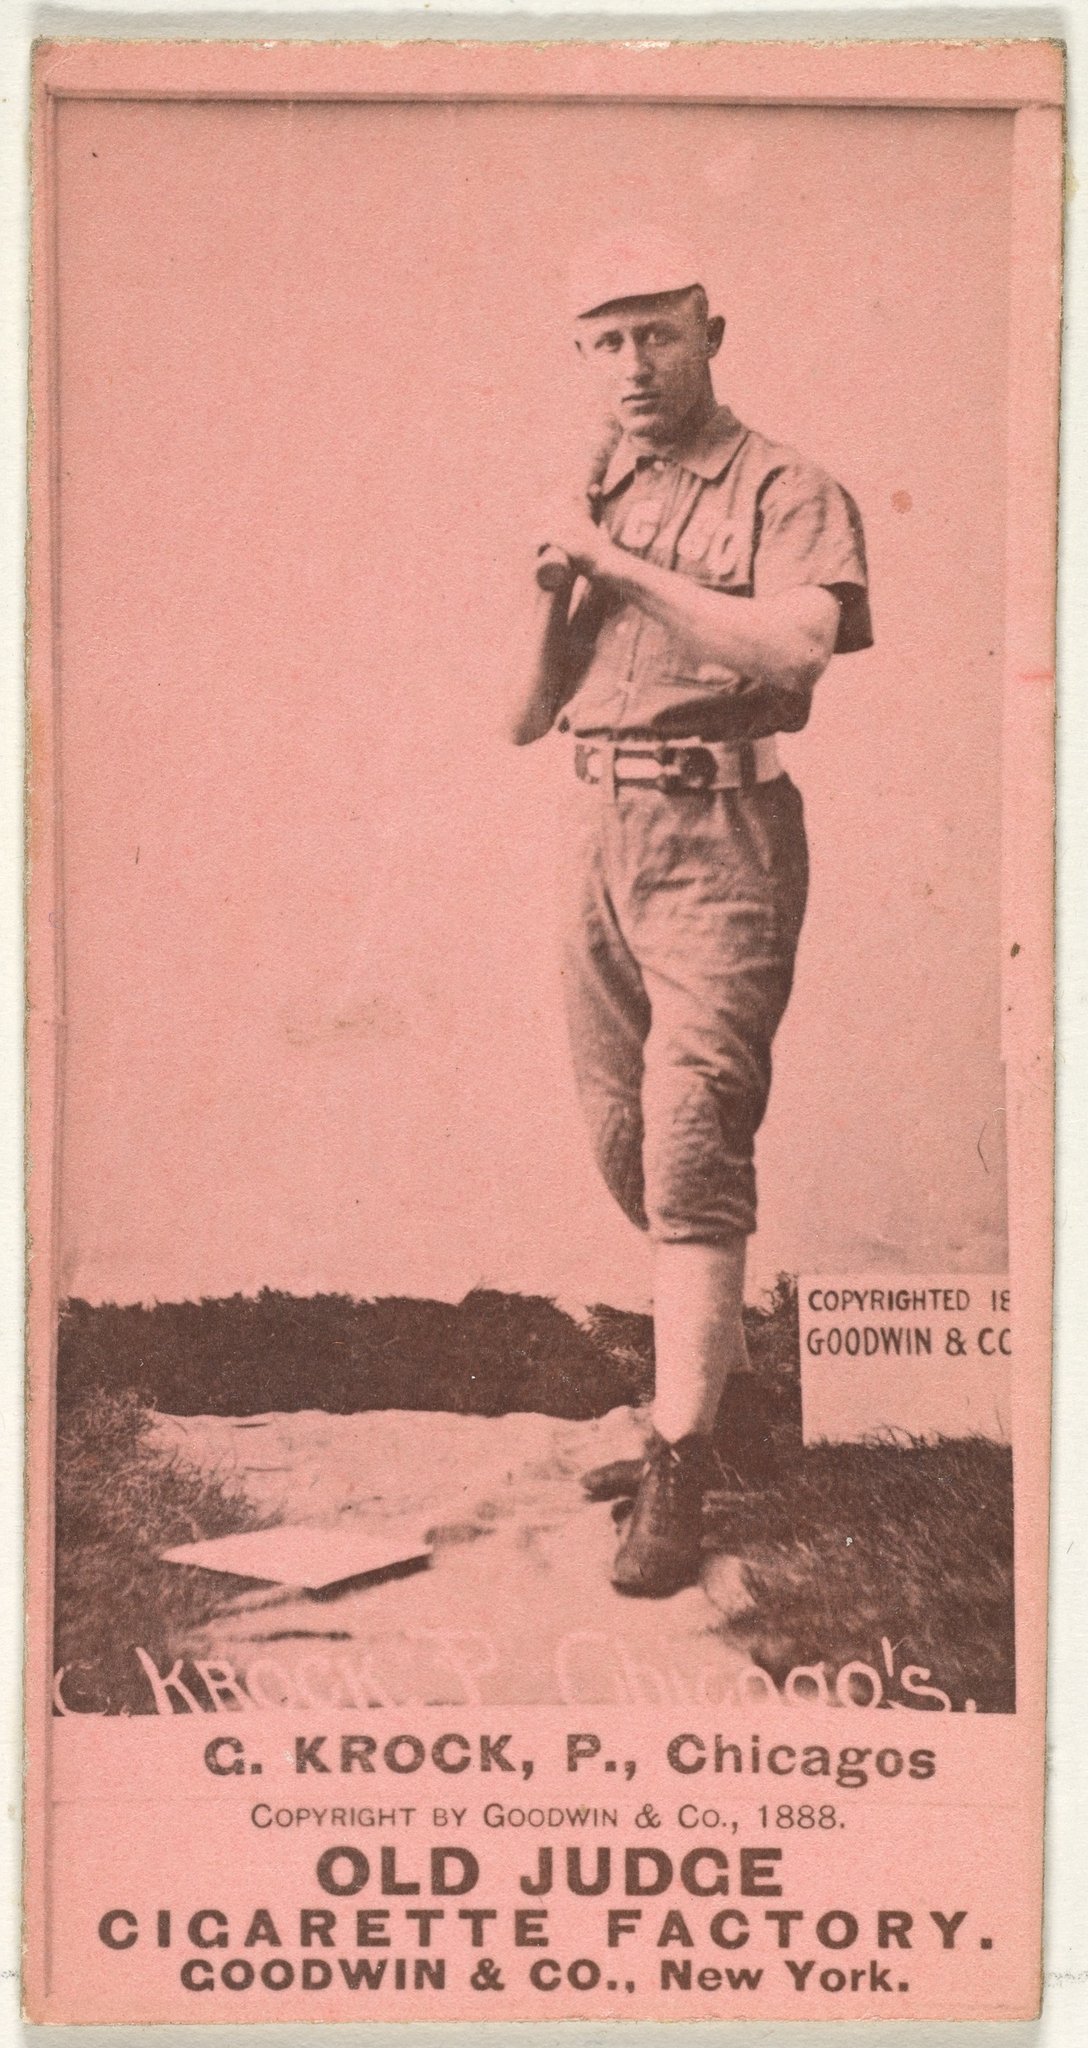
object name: baseball card, photograph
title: August H. "Gus" Krock, Pitcher, Chicago, from the Old Judge series (N172) for Old Judge Cigarettes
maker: goodwin & company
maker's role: publisher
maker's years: 1850-1950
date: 1888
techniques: albumen silver print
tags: men,portraits,baseball,athletes